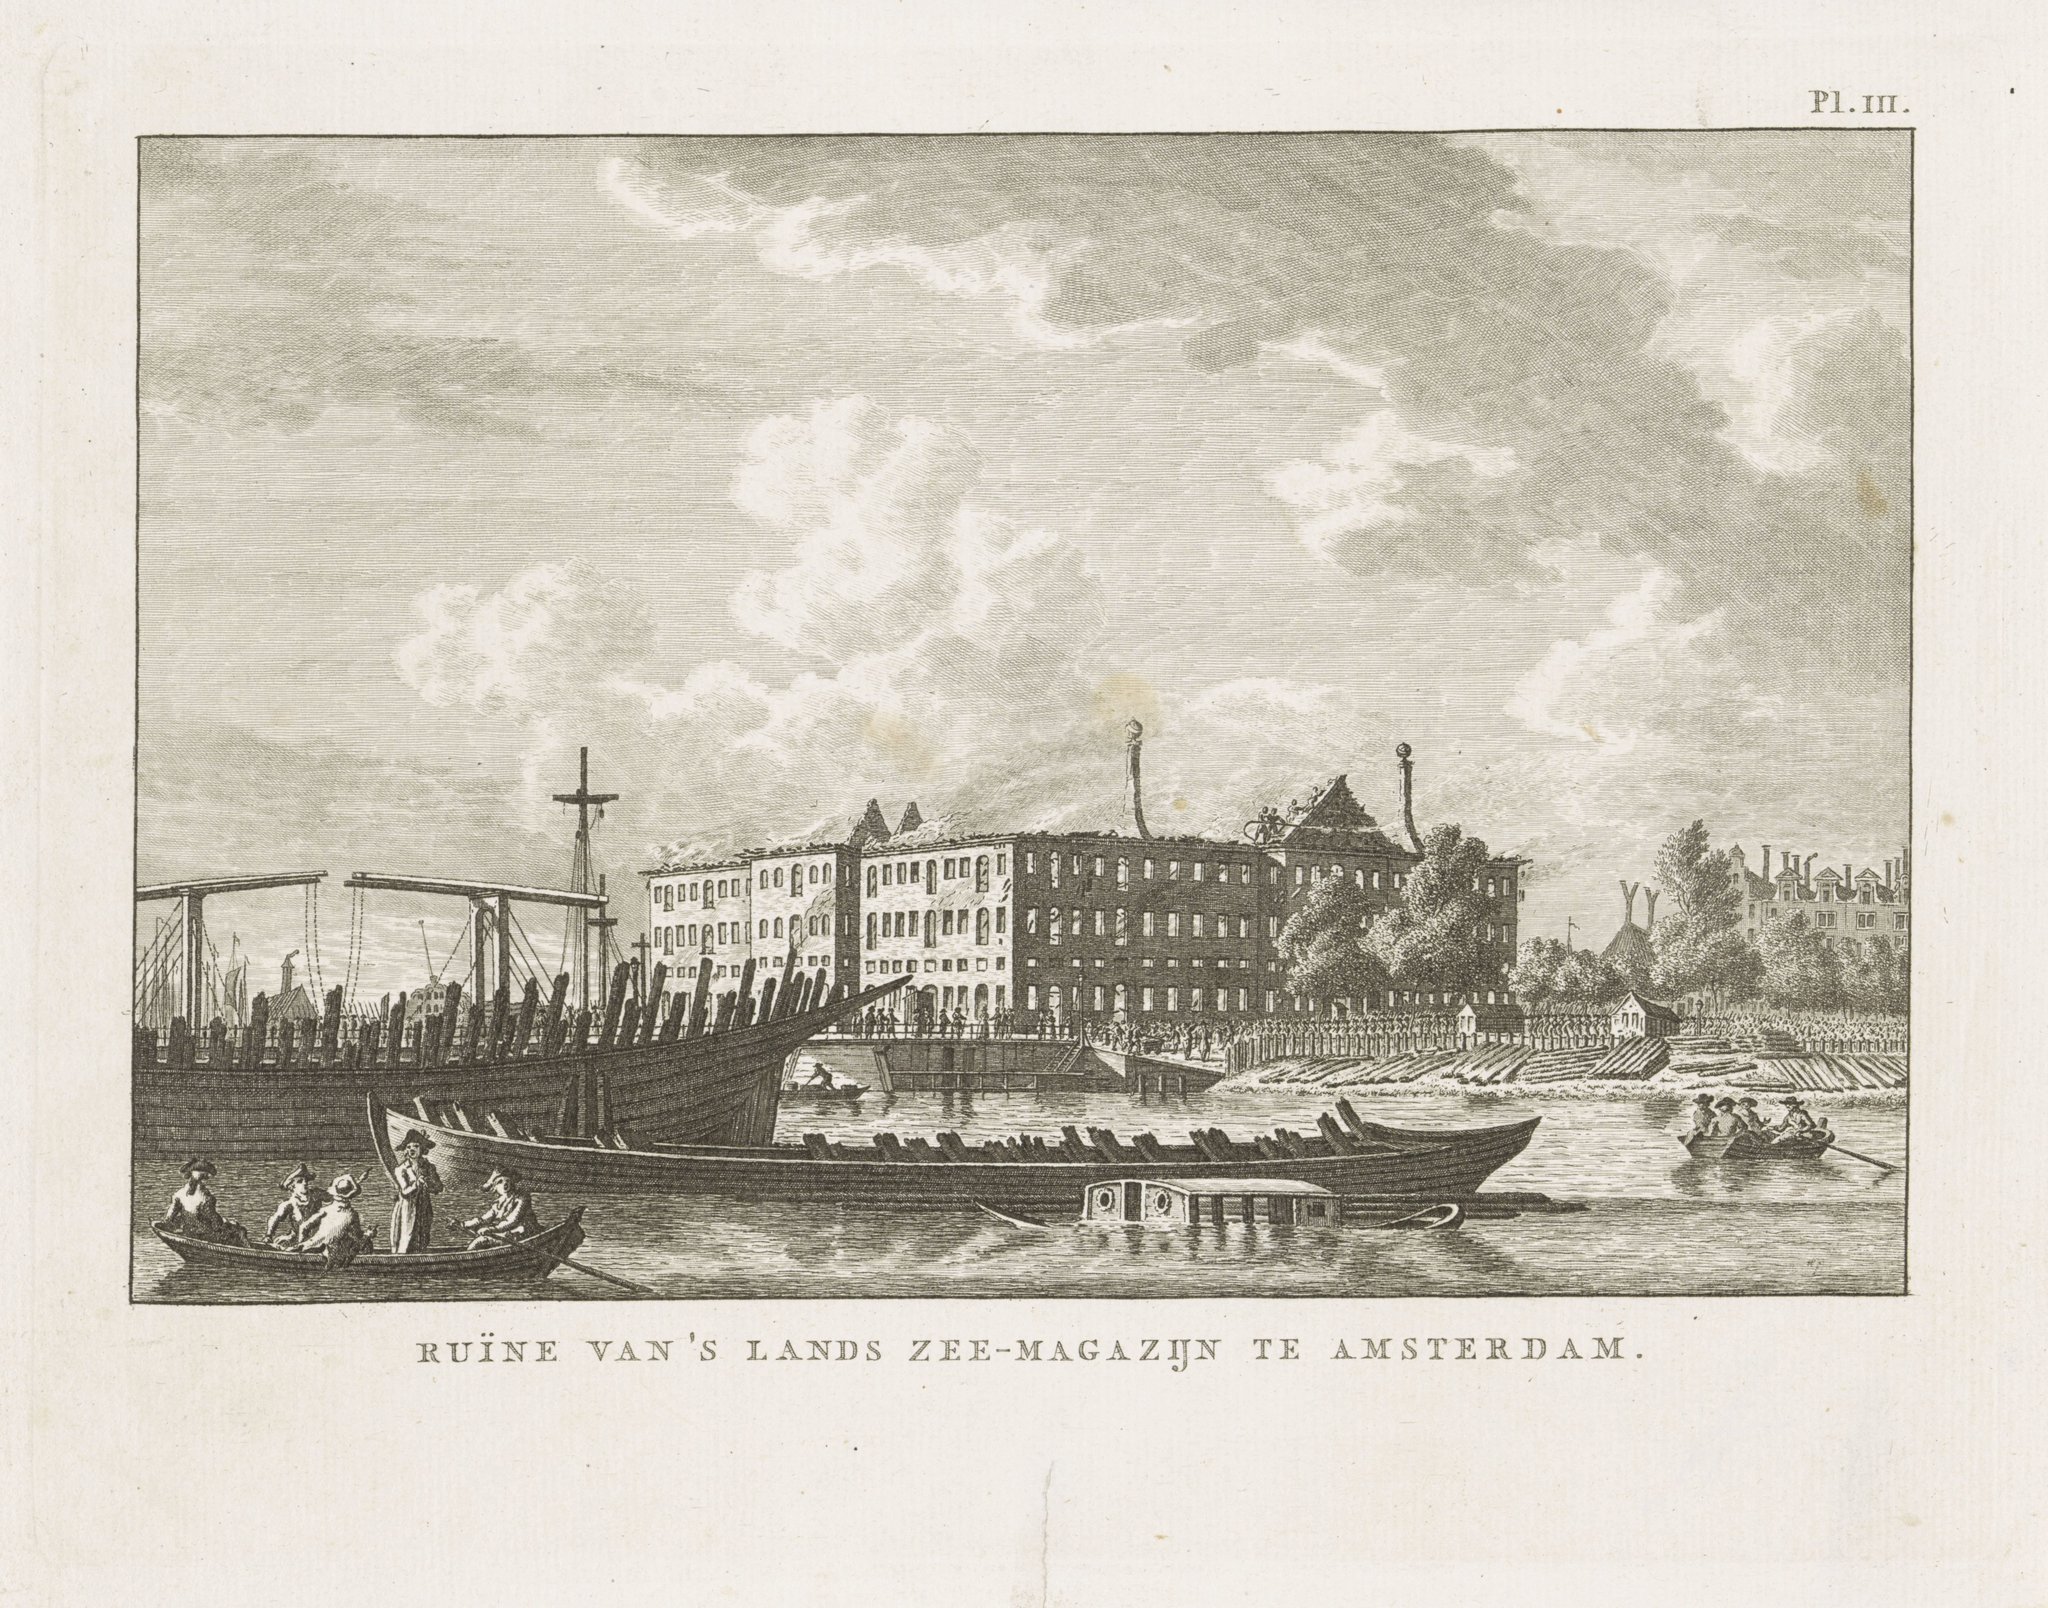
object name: print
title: 's Lands Zeemagazijn in welstand, tijdens en na de brand in 1791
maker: Anonymous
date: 1791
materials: paper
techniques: engraving, etching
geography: northern netherlands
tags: on fire, ablaze, ruin of a building ~ architecture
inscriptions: collector's mark: Lugt 2228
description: Gebruikt als illustratie in: 'sLands zee-magazĳn, te Amsterdam, beschouwd vóór, bĳ en na den geweldigen brand van (...) julĳ deezes jaars. Amsterdam: J.W. Smit, 1791.